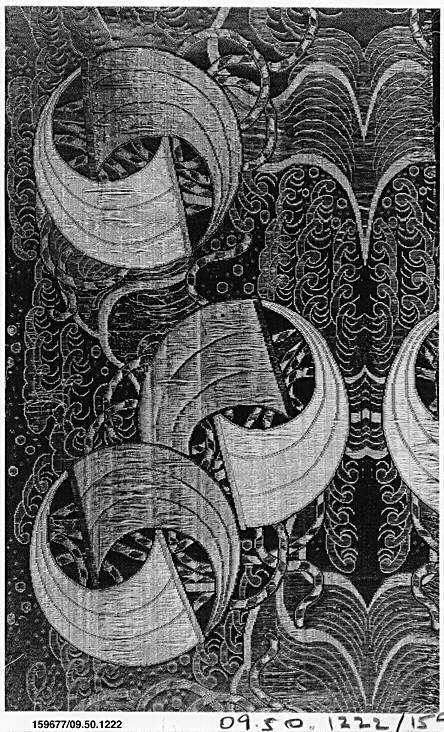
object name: piece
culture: japanese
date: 1701-1800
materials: textile